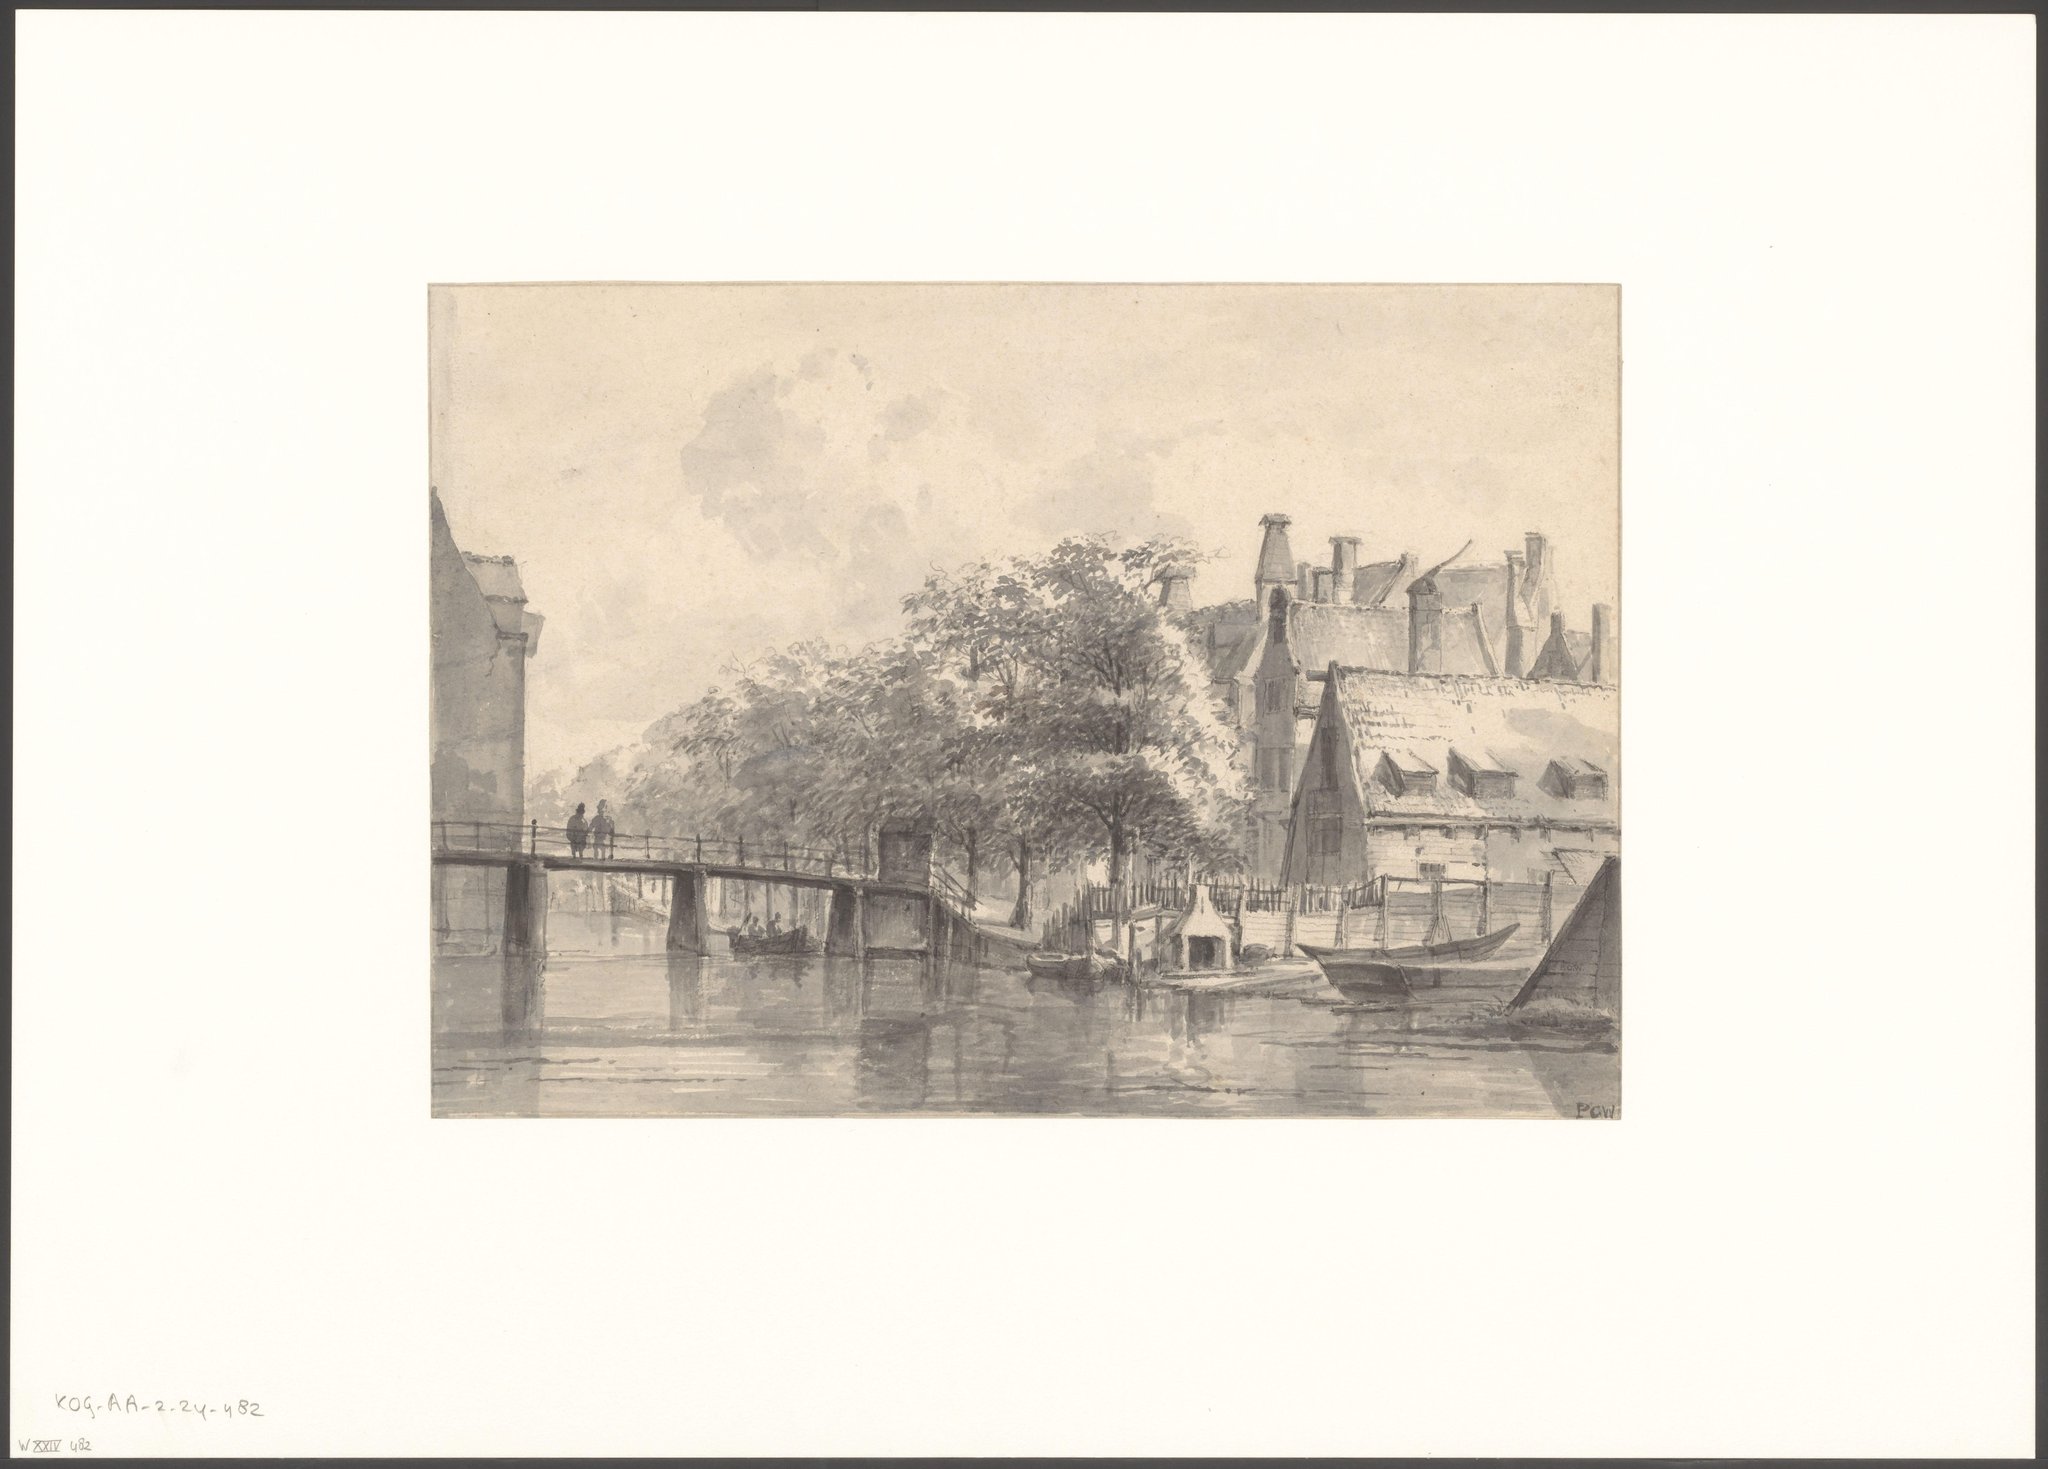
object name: drawing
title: Gezicht op de Lijnbaansgracht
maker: george pieter westenberg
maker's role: draughtsman, painter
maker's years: 1791-1873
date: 1839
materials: chalk, ink, paper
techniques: brush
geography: amsterdam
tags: city-view in general; 'veduta', canal, bridge in city across river, canal, etc.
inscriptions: signature and date: ‘P:G:Westenberg. fecit 1839.-’, inscription: ‘Gezigt bij de (...) Spiegelplein / te amsterdam.’, collector's mark: Lugt 800a, signature: ‘PCW’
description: Tekening binnen de Atlas Van Eck ingedeeld op wijknummer 24.